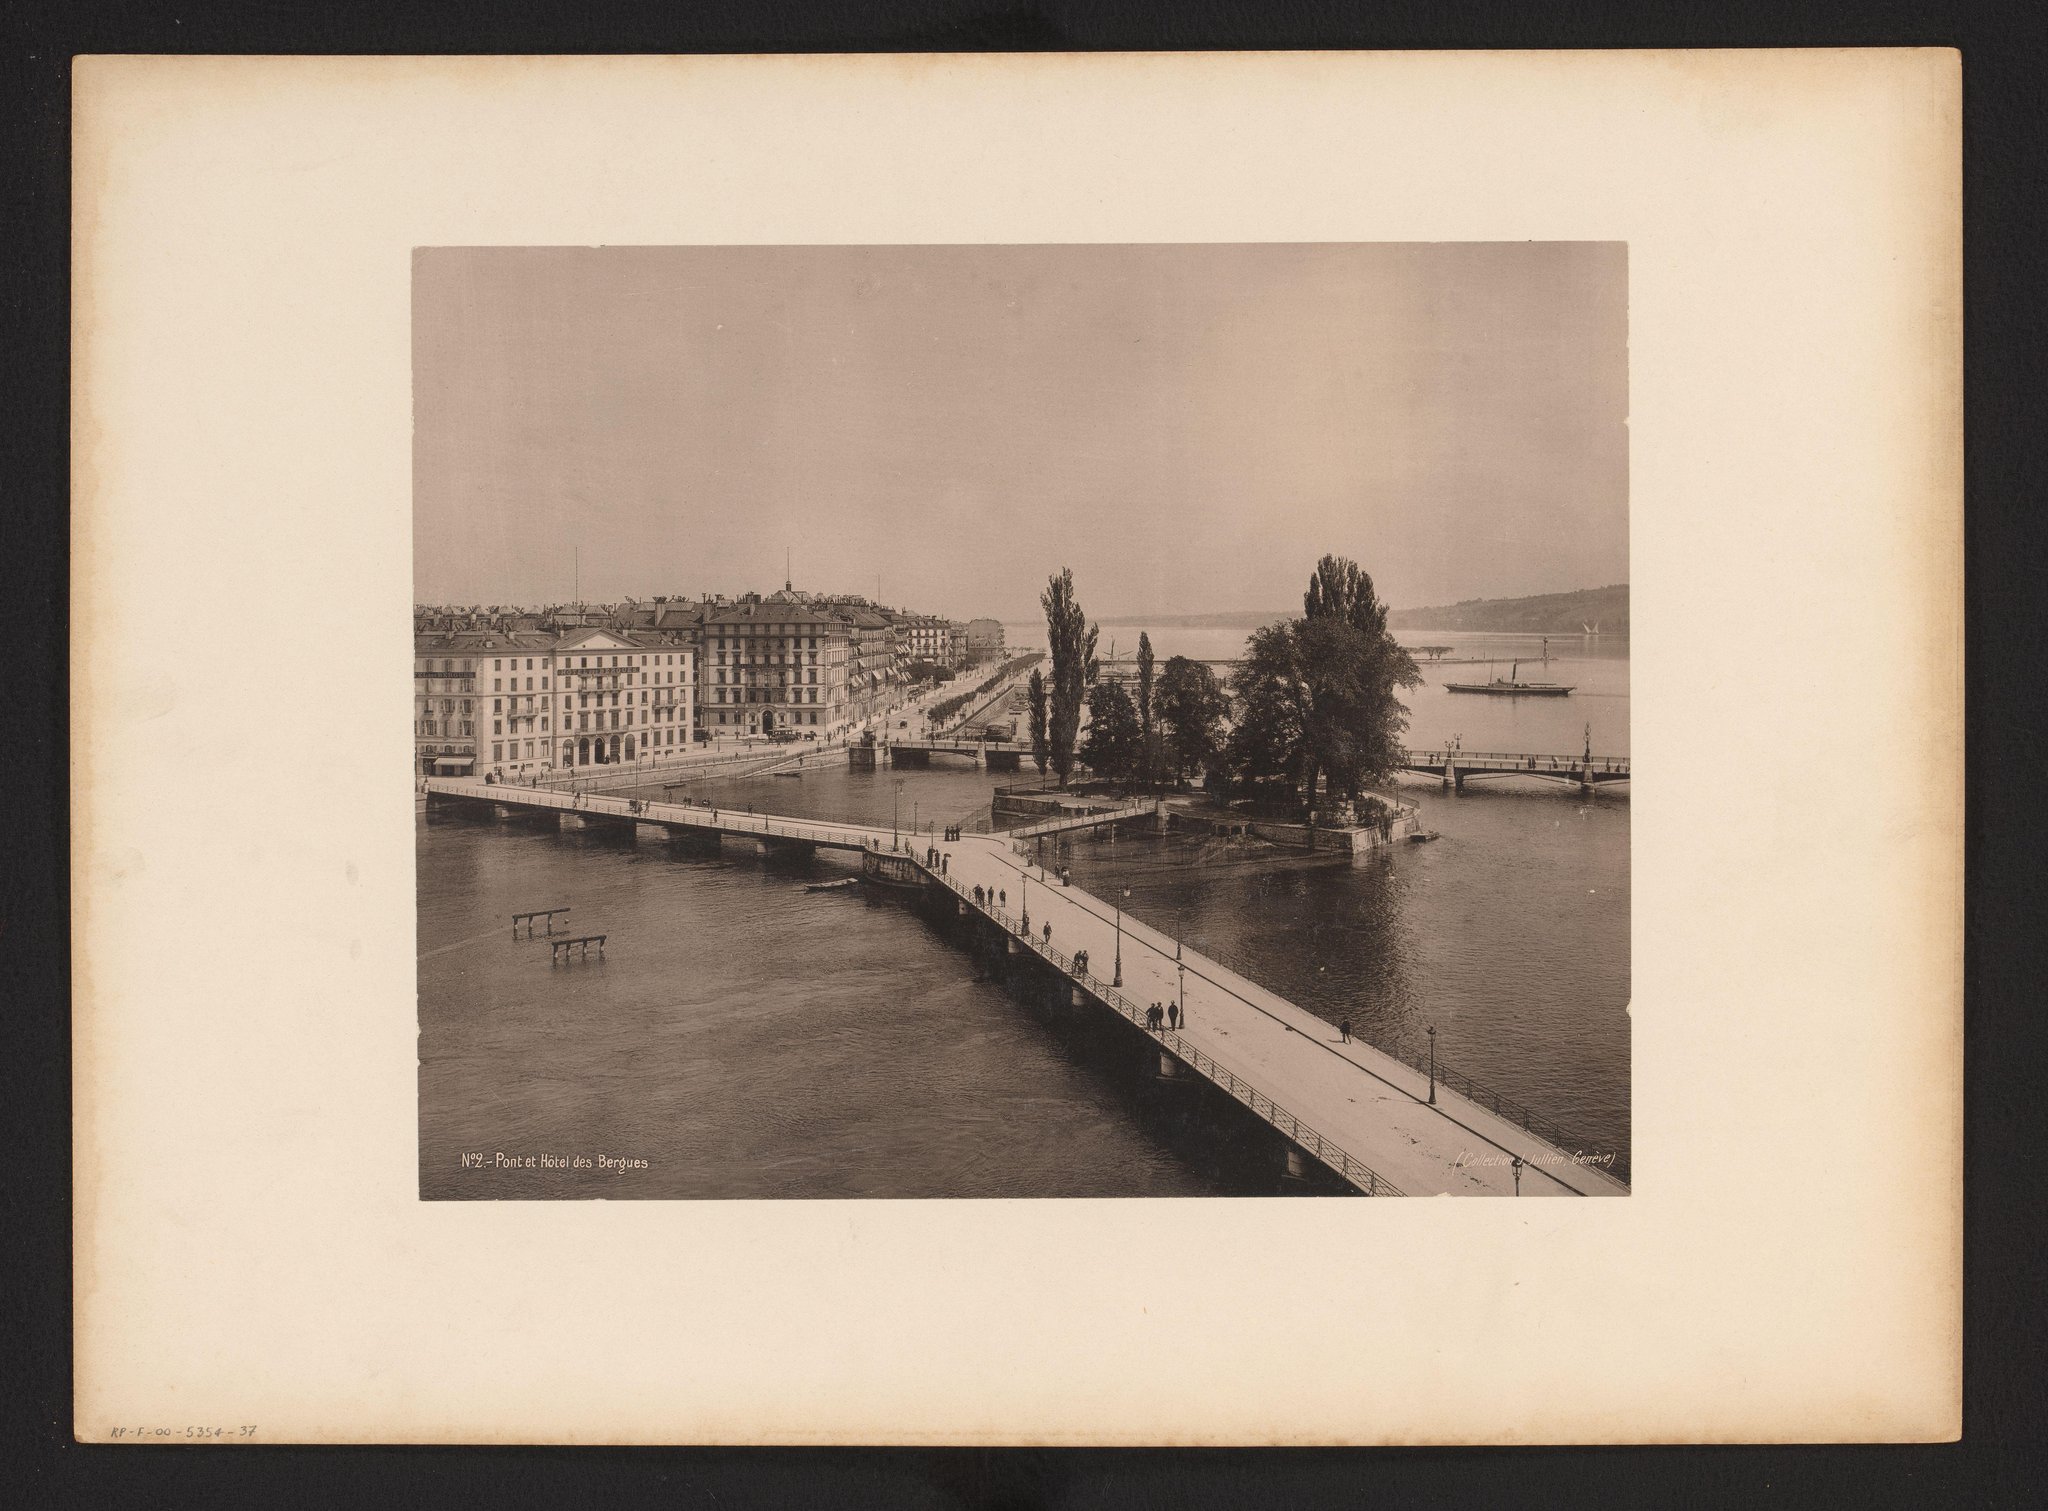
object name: photomechanical print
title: Pont et Hôtel des Bergues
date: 1885-1910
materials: cardboard, paper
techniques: photograph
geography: geneva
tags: island, lake, bridge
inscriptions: inscription: ‘No.2.- Pont et Hôtel des Bergues (Collection J. Jullien, Genève)’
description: Deze fotomechanische afdruk maakt deel uit van een omslag.